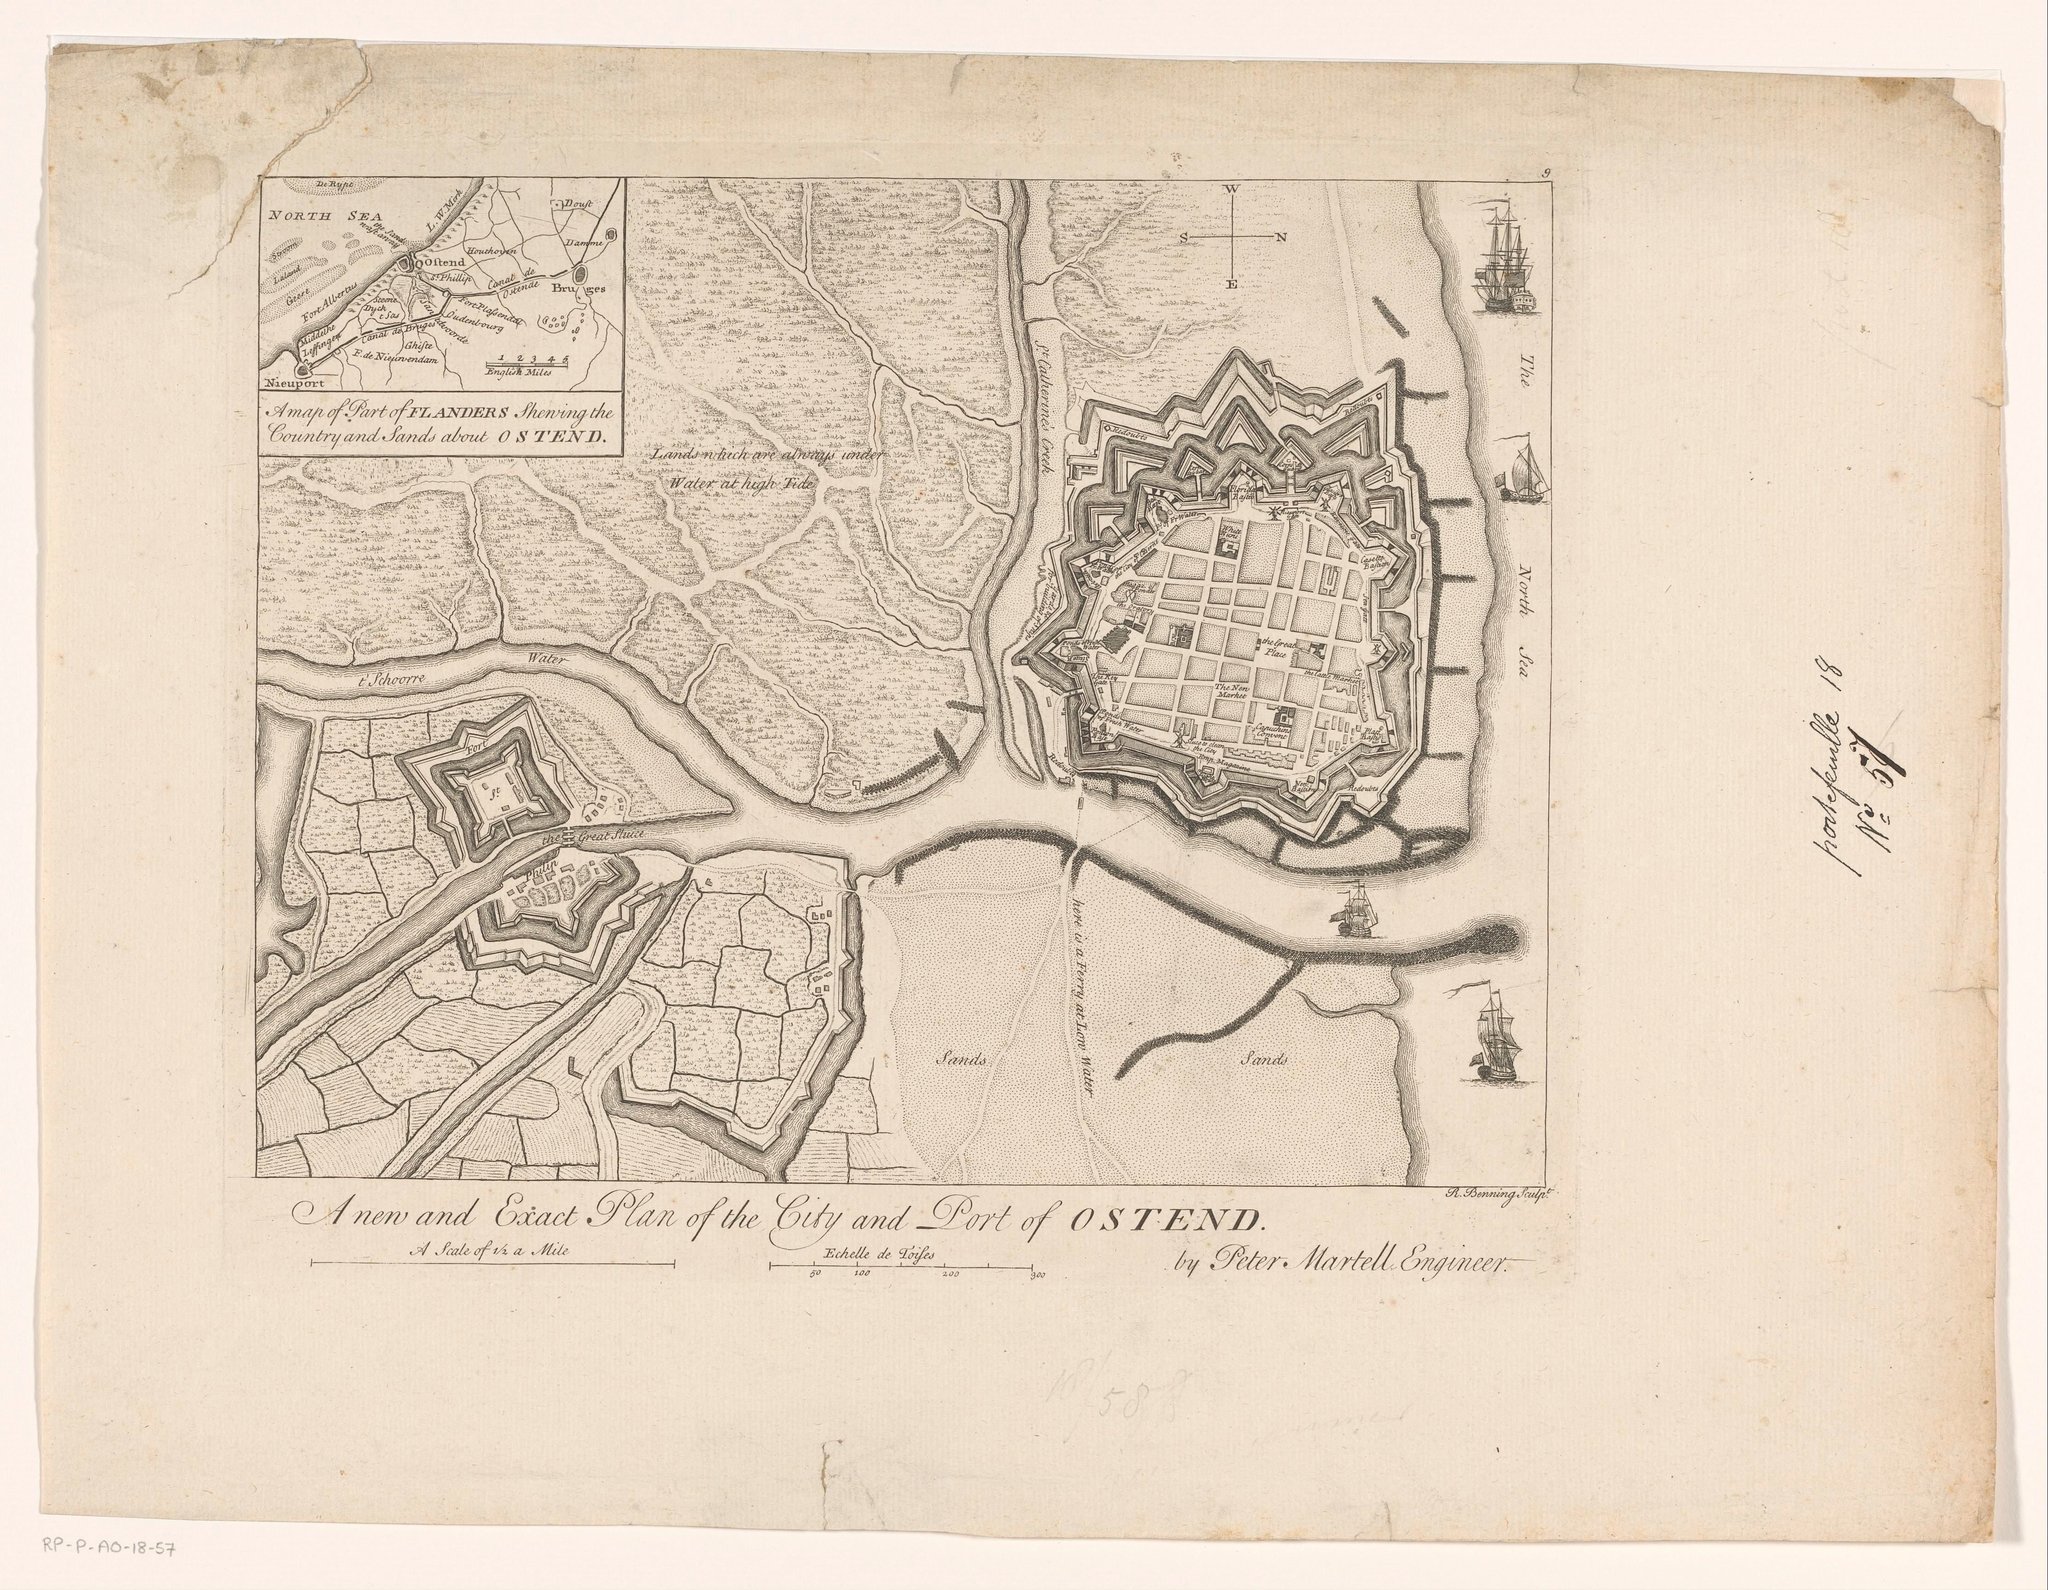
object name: area plan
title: A new and exact plan of the city and port of Ostend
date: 1711-1761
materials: paper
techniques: engraving, etching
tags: maps of separate countries or regions, fortified city, maps of cities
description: Plattegrond van Oostende. Onder de prent de titel en twee schaalstokken: A Scale of 1/2 a Mile / 300 Eschelle de Toises. Linksboven een inzet met een kaart van de omgeving van Oostende. In deze kaart een schaalstok: 5 English Miles. Rechtsboven genummerd: 9.